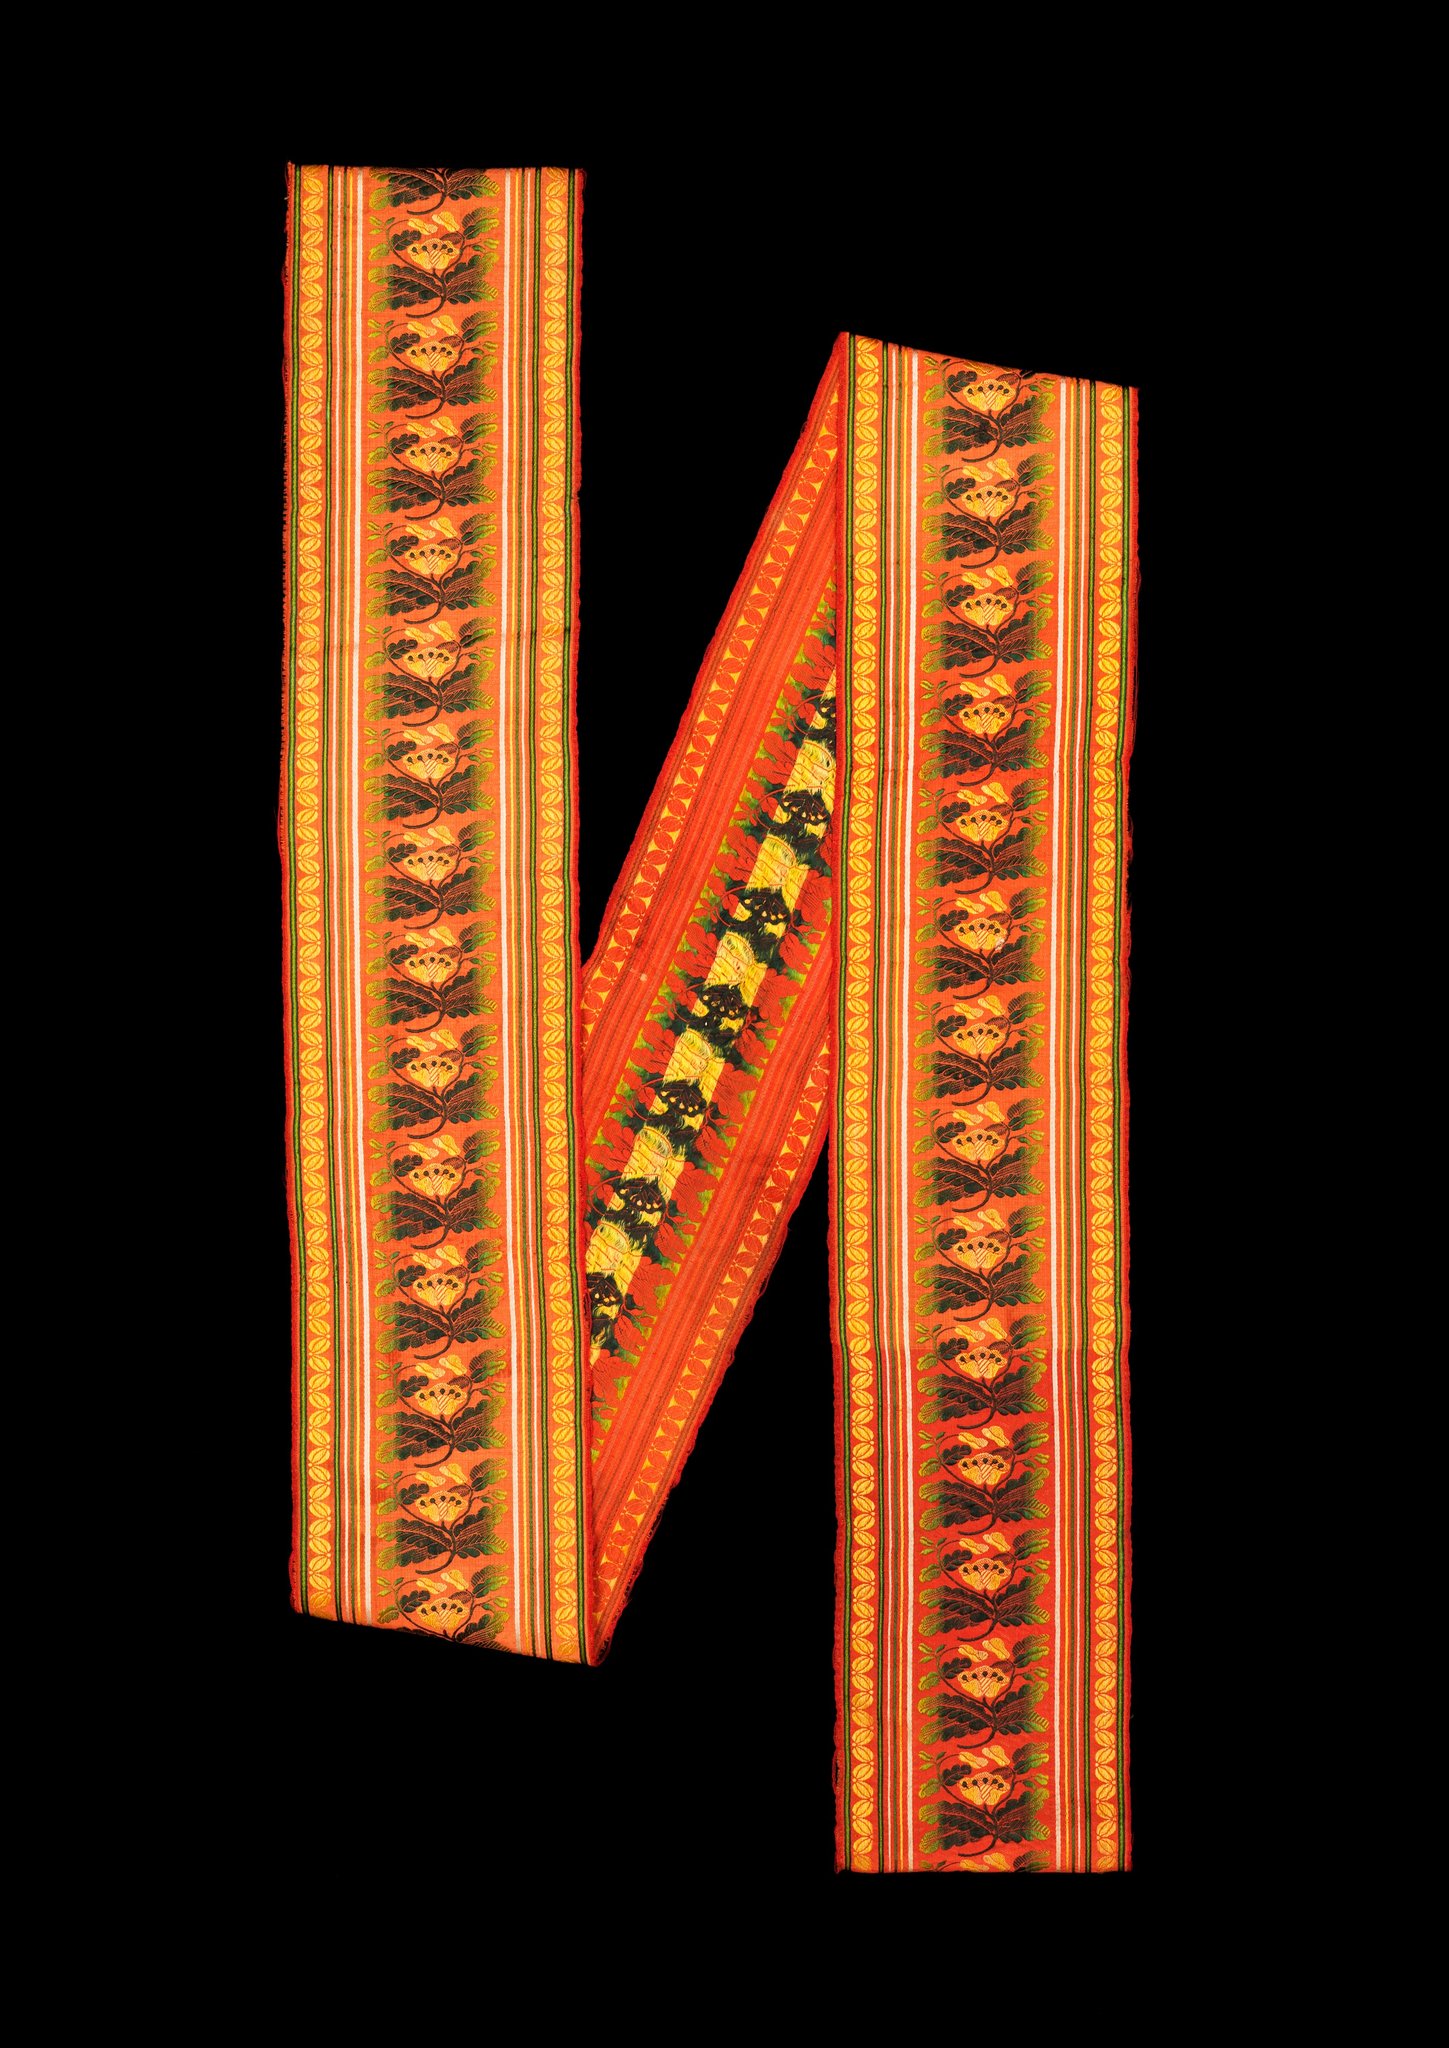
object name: ribbon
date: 1801-1833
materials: silk